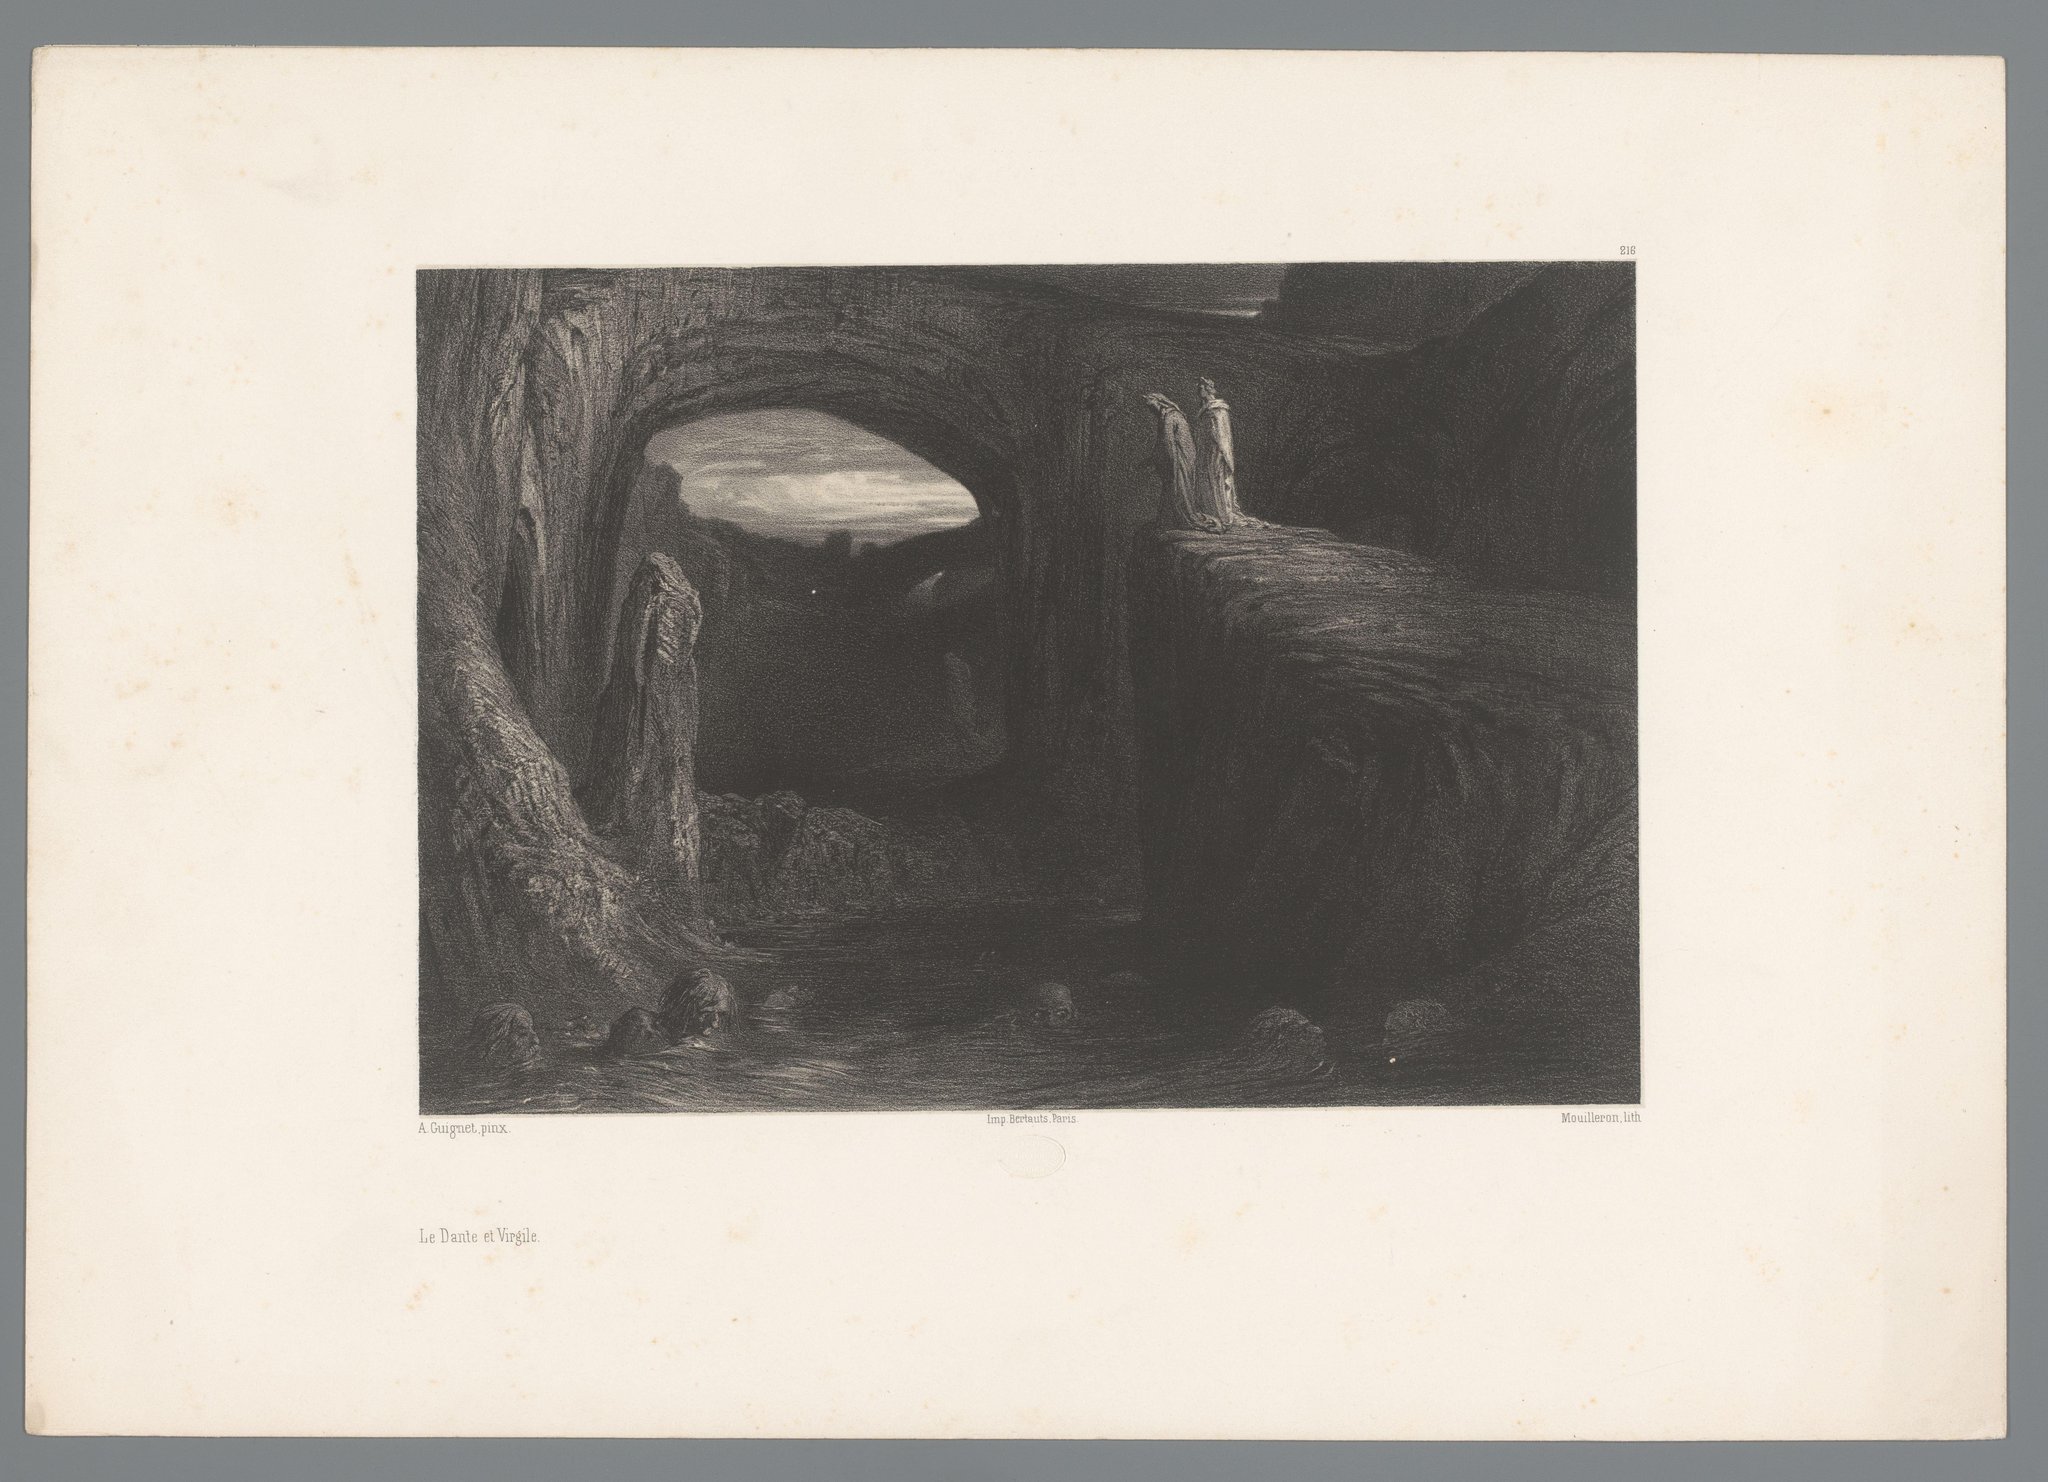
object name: print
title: Les artistes anciens et modernes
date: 1848-1862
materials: paper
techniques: lithograph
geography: paris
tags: (scenes from) specific works of literature: dante, divina commedia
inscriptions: collector's mark: Lugt 2228